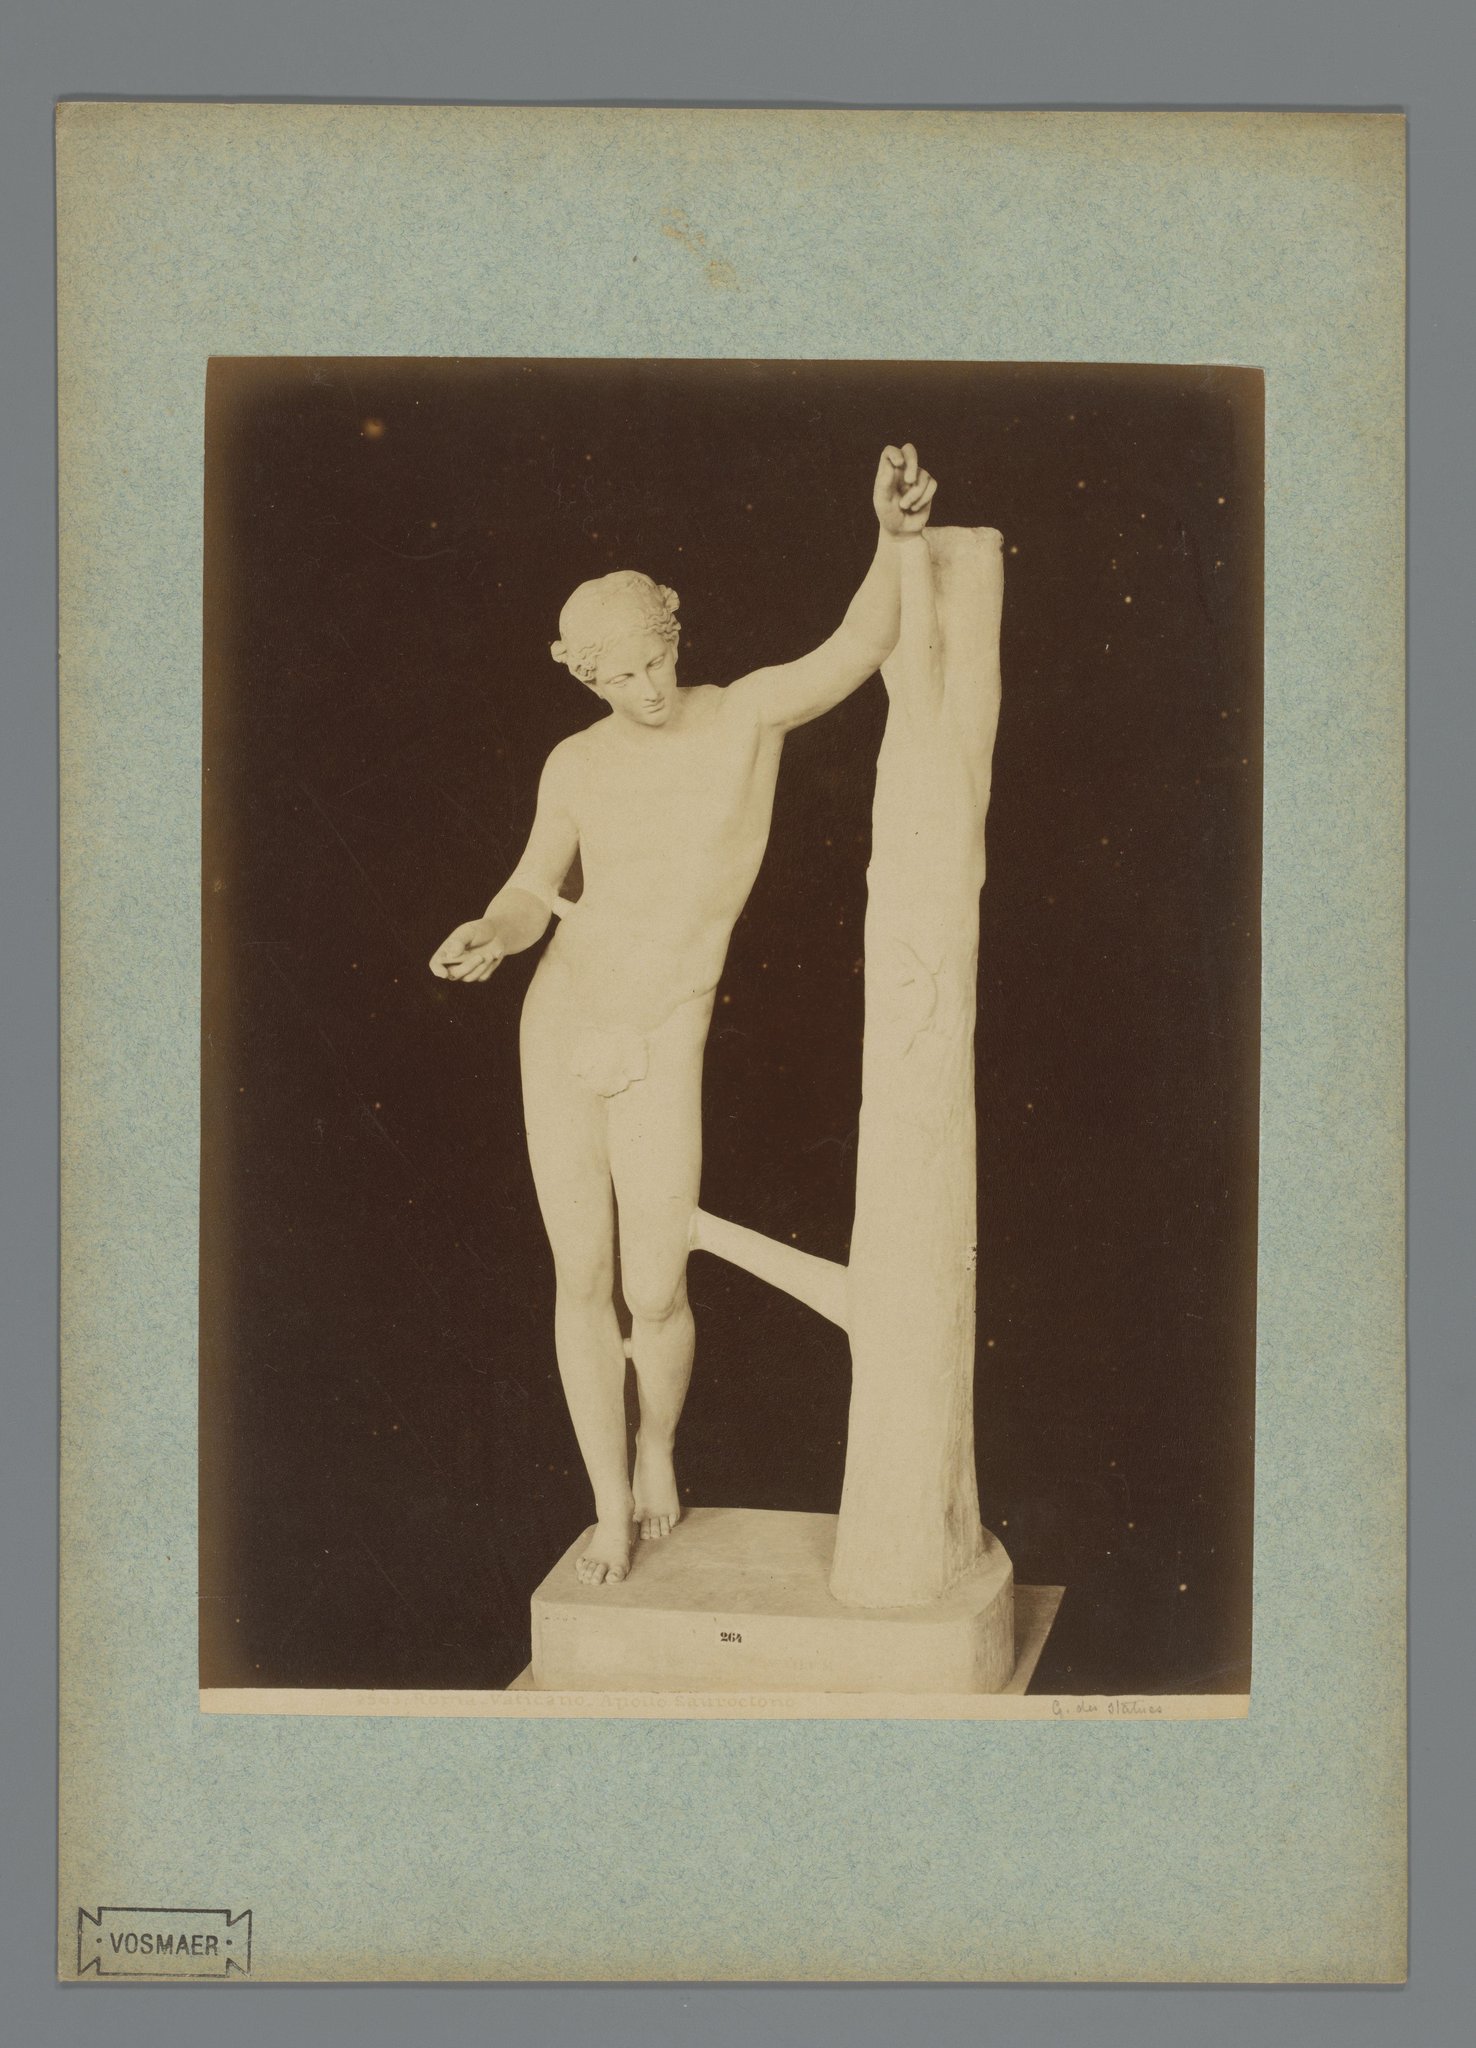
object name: photograph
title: Vaticano. Apollo Sauroctono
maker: Anonymous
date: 1851-1890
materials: cardboard, paper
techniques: albumen print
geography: vatican city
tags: (story of) apollo (phoebus), piece of sculpture, reproduction of a piece of sculpture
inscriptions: collector's mark: ‘VOSMAER’, inscription: ‘G. des statues’, number: ‘2563’